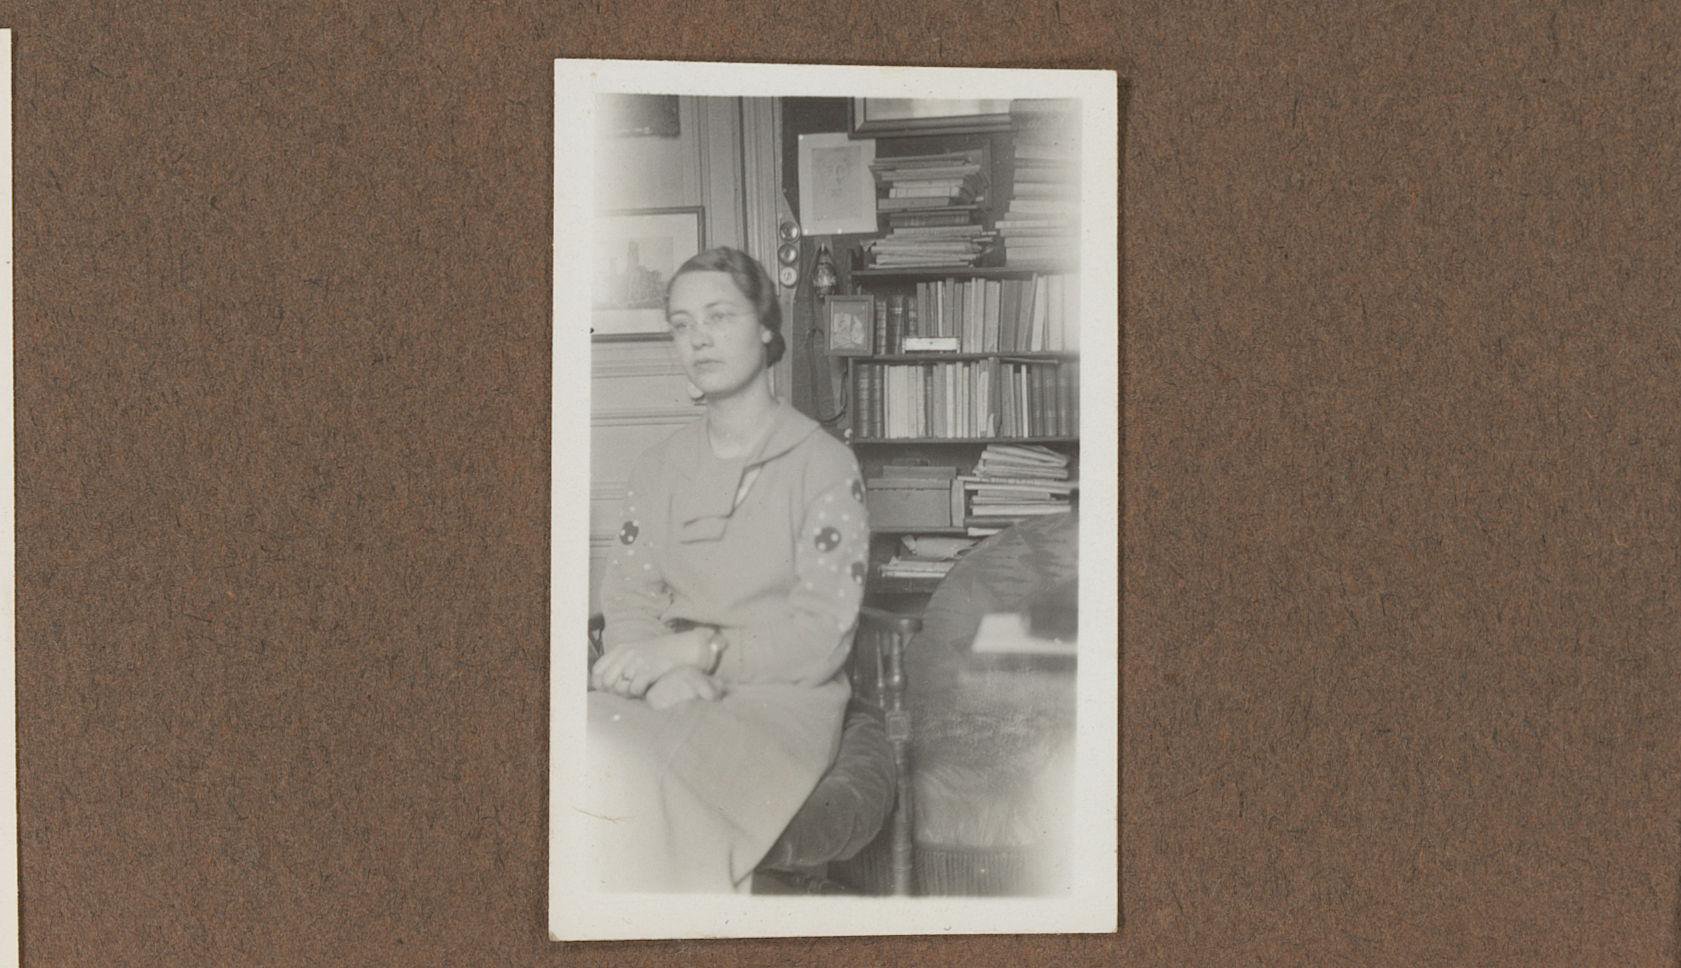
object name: photograph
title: Jonge vrouw voor boekenkast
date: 1900-1920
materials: photographic support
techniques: photography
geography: netherlands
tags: netherlands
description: Foto op bruin albumblad 54 van familiealbum van Alphons Diepenbrock.